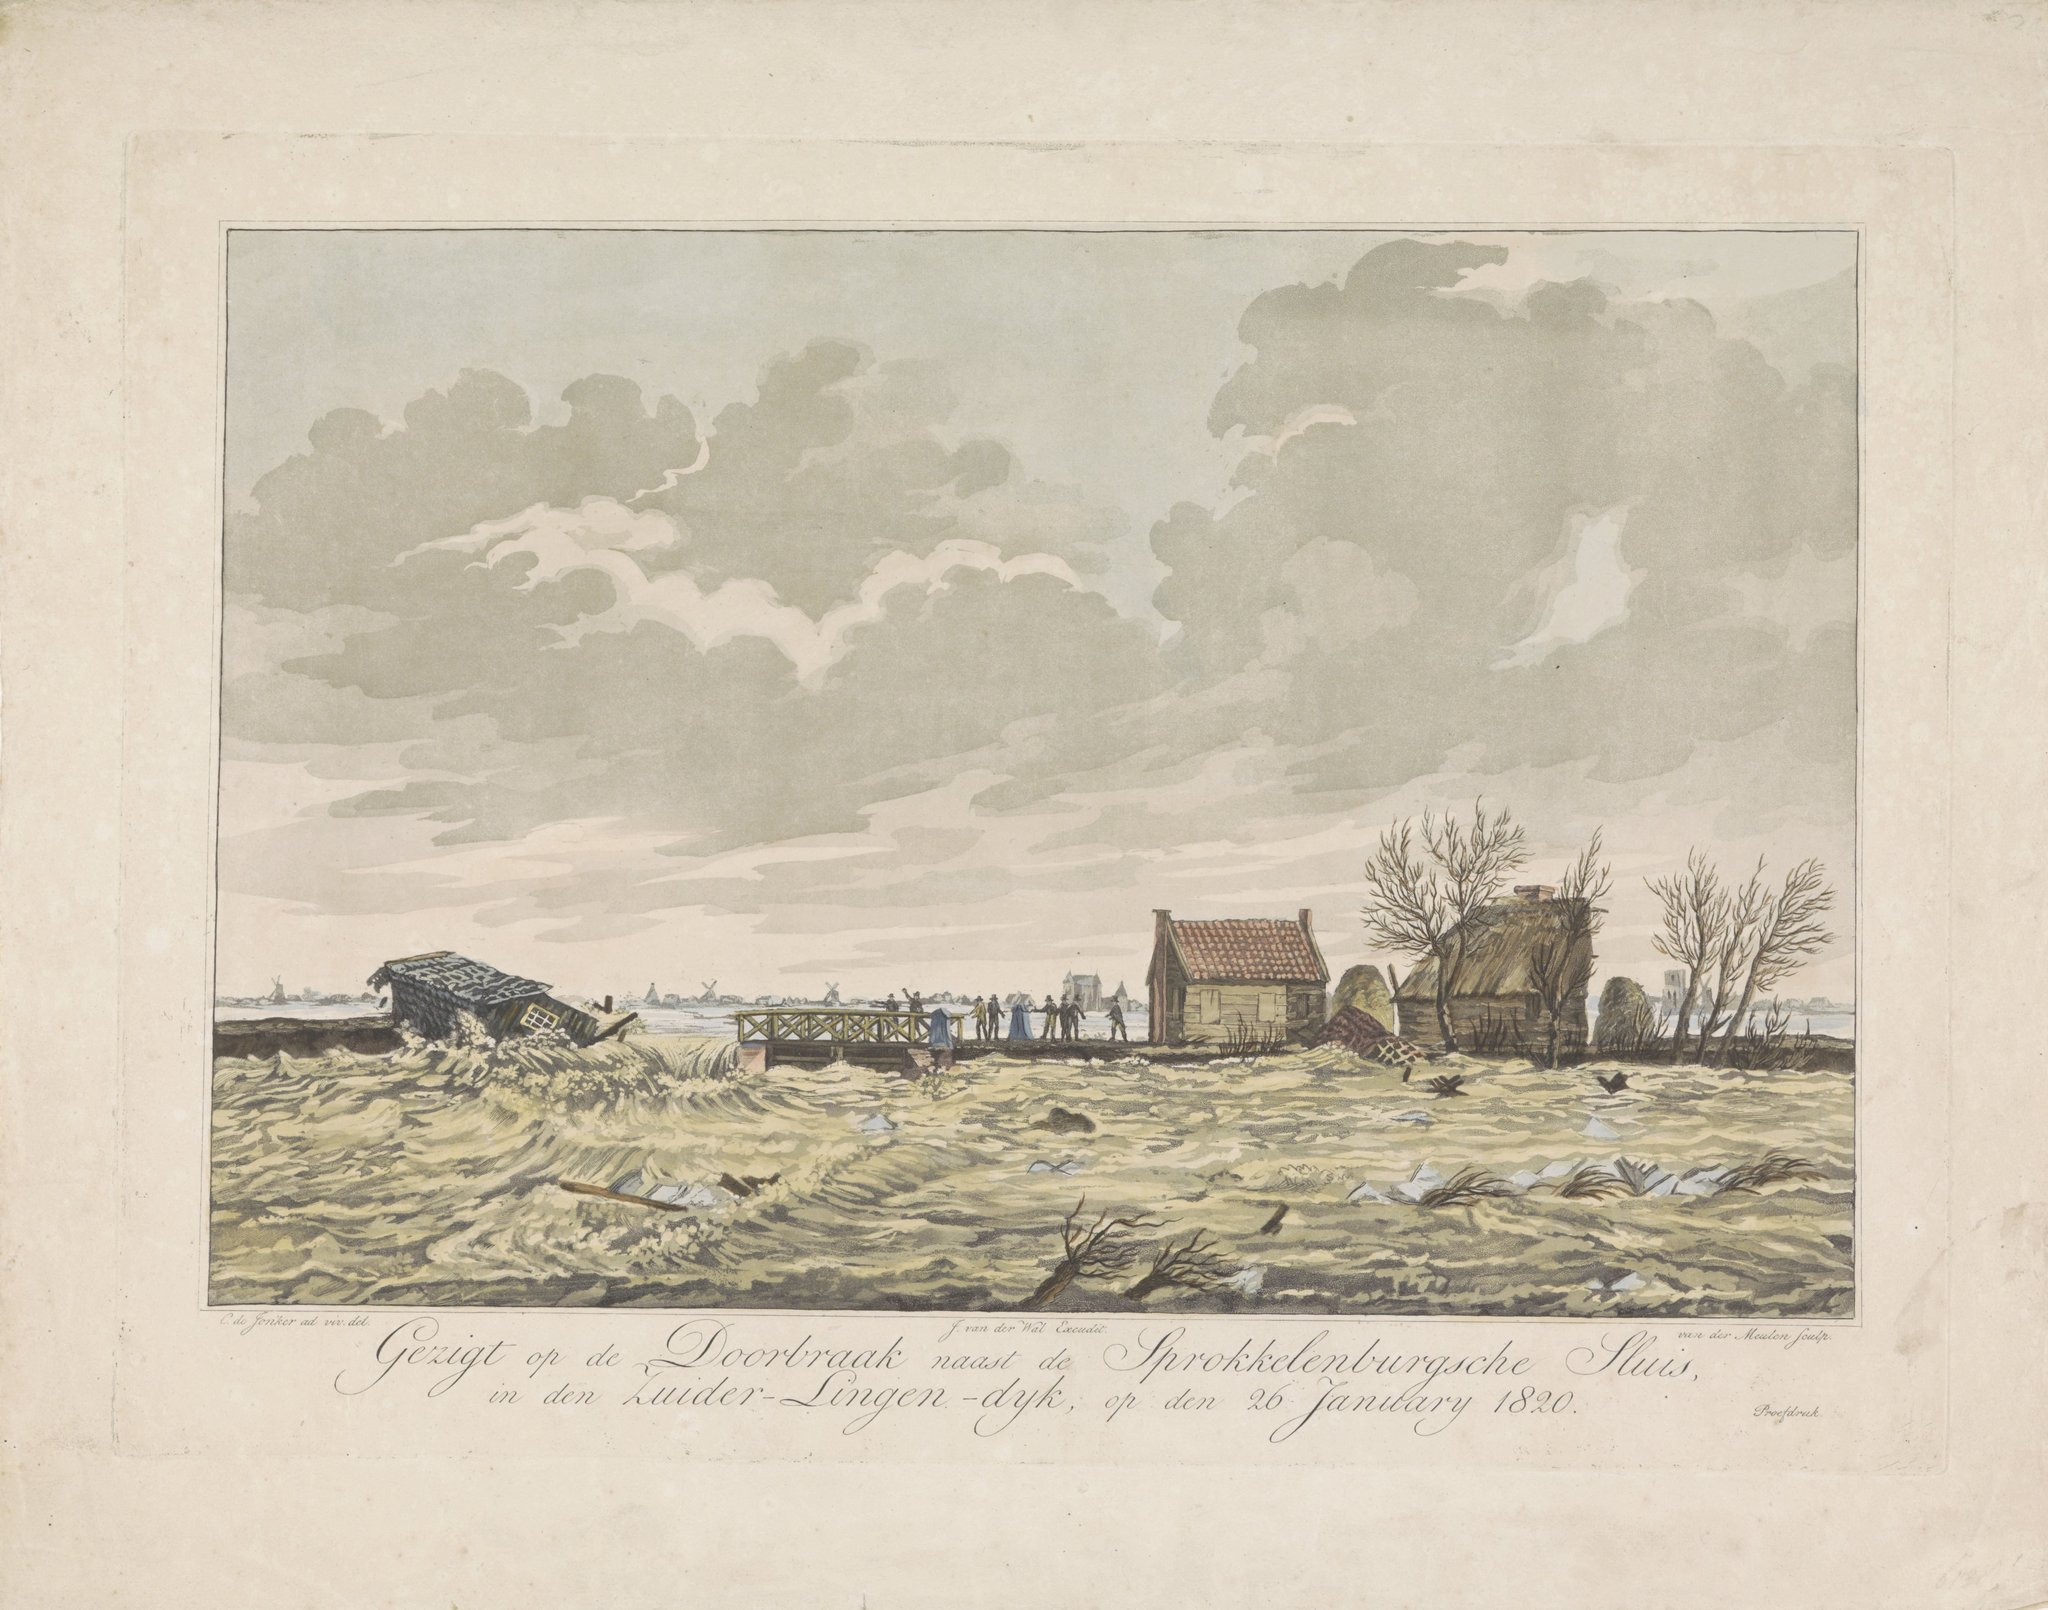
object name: print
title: Gezigt op de Doorbraak naast de Sprokkelenburgsche Sluis, in den Zuider-Lingen-dyk, op den 26 January 1820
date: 1820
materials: paper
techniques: aquatint, etching, hand coloring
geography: gorinchem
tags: sluice, weir, dike-break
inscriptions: collector's mark: Lugt 2228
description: Dijkdoorbraak van de Zuiderlingedijk naast de Sprokkelenburg Sluis buiten Gorinchem op 26 januari 1820. Op de dijk kijken mensen hoe een huis wordt weggespoeld.